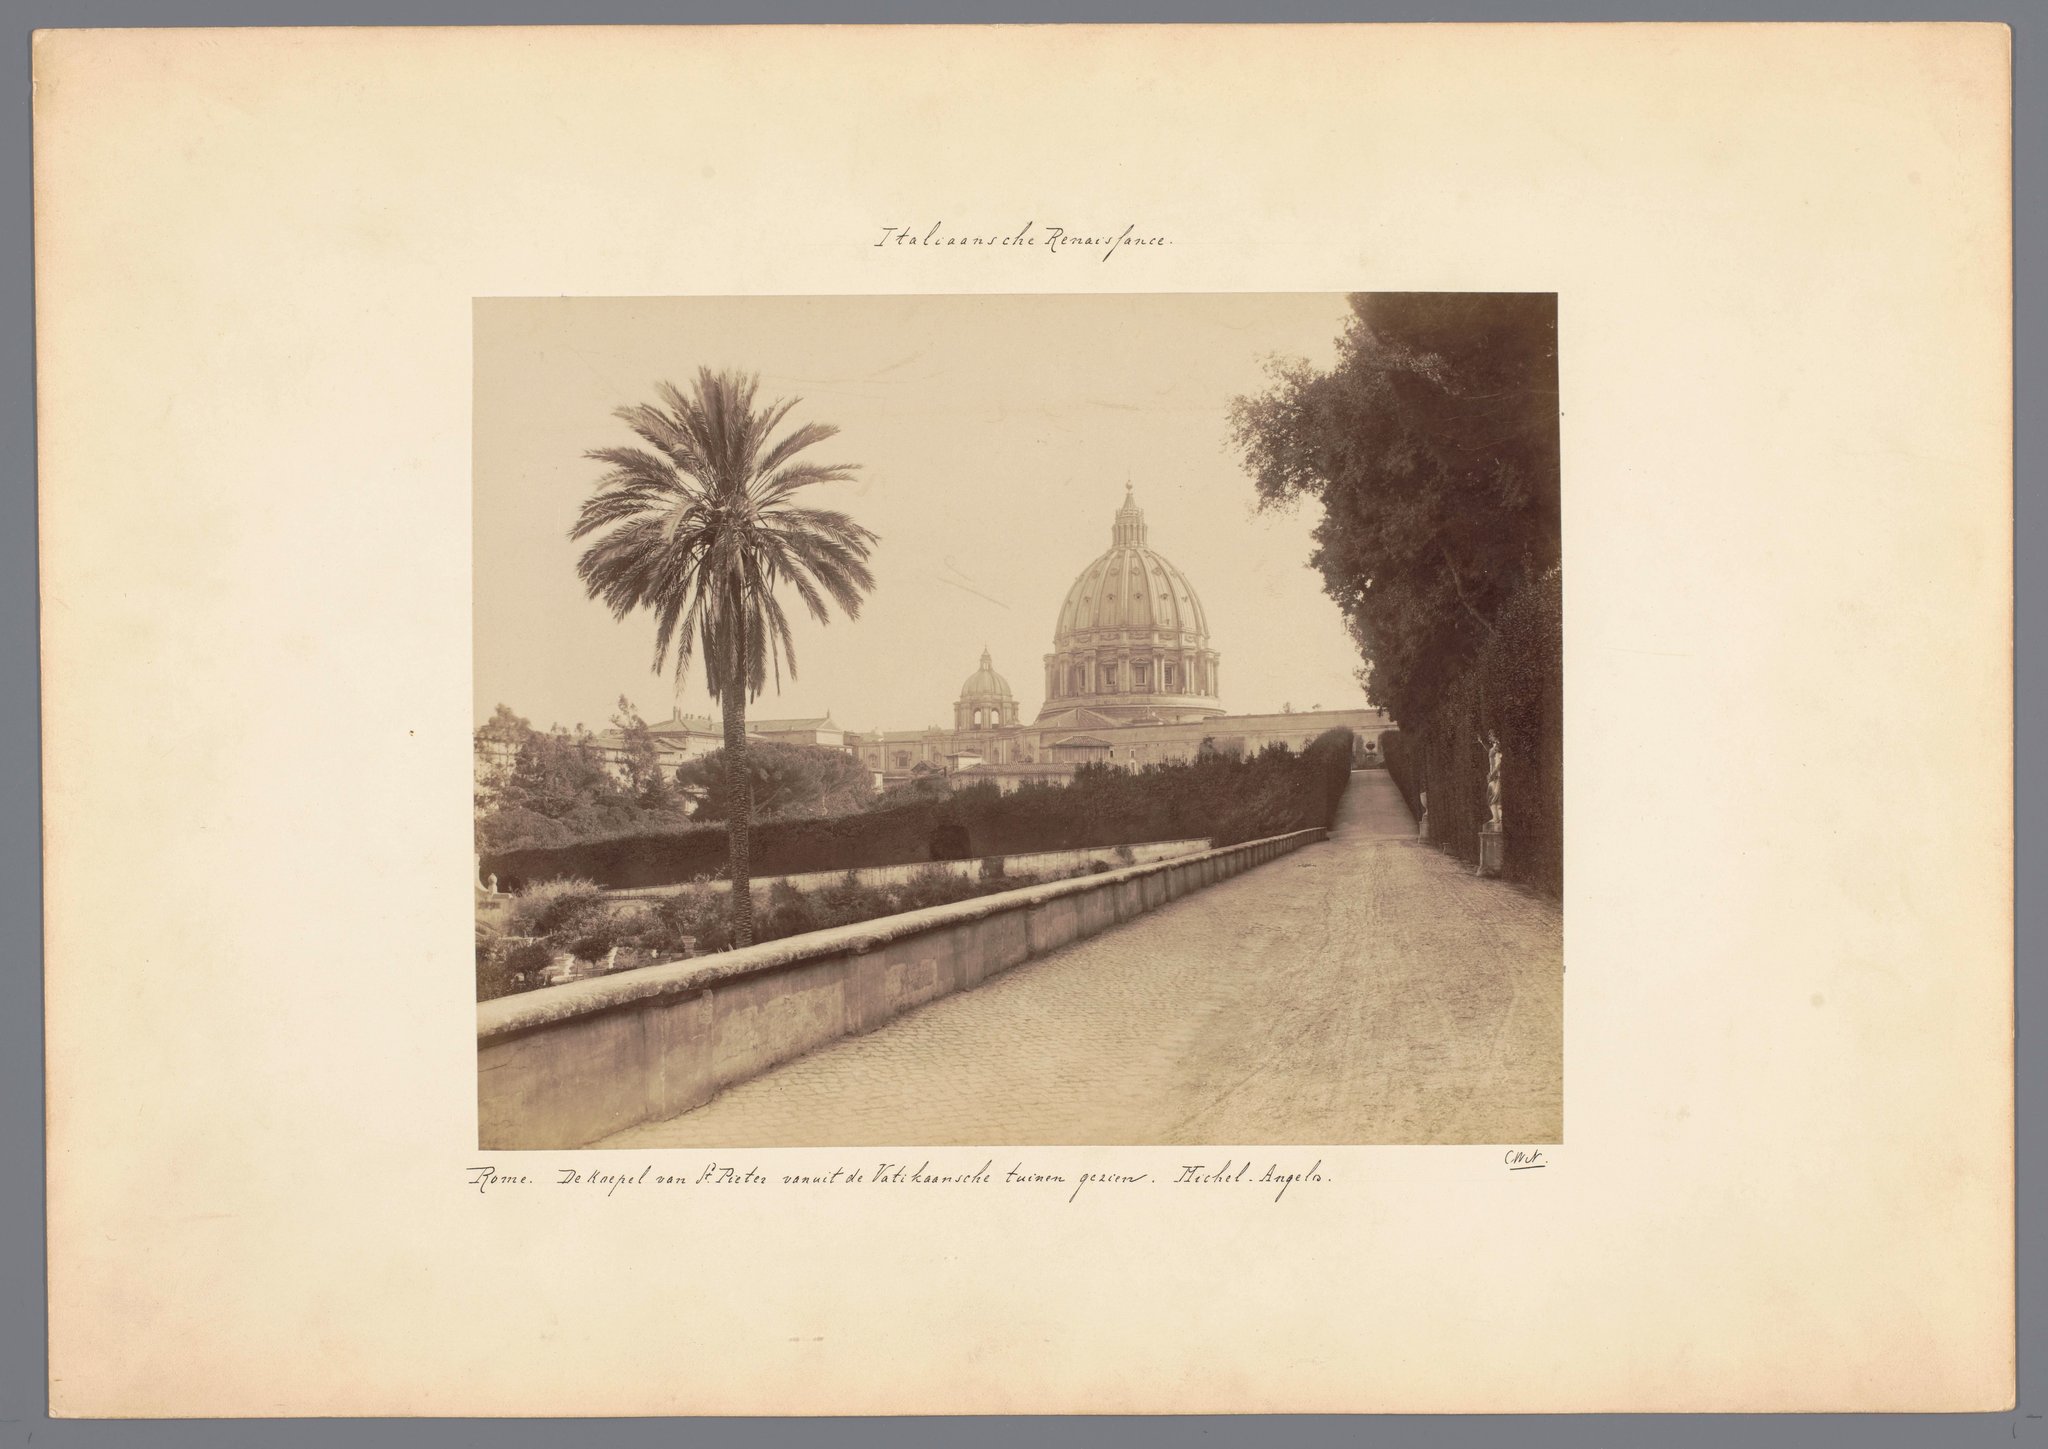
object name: photograph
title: Rome. De koepel van St. Pieter vanuit de Vatikaansche tuinen gezien.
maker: Anonymous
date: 1875-1900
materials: cardboard, photographic support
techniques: albumen print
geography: vatican city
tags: parts of church exterior and annexes: dome, trees: palm-tree, avenue, boulevard, promenade, esplanade, public gardens, park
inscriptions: collector's mark: ‘KUNSTNIJVERHEIDSCHOOL QUELLINUS AMSTERDAM FRANS HALSSTRAAT 14.’, inscription: ‘Italiaansche Renaissance.’, collector's mark: ‘INSTITUUT VOOR KUNST-NIJVERHEIDSONDERWIJS GABRIËL METSUSTRAAT No. 16 AMSTERDAM’, inscription: ‘CWN.’